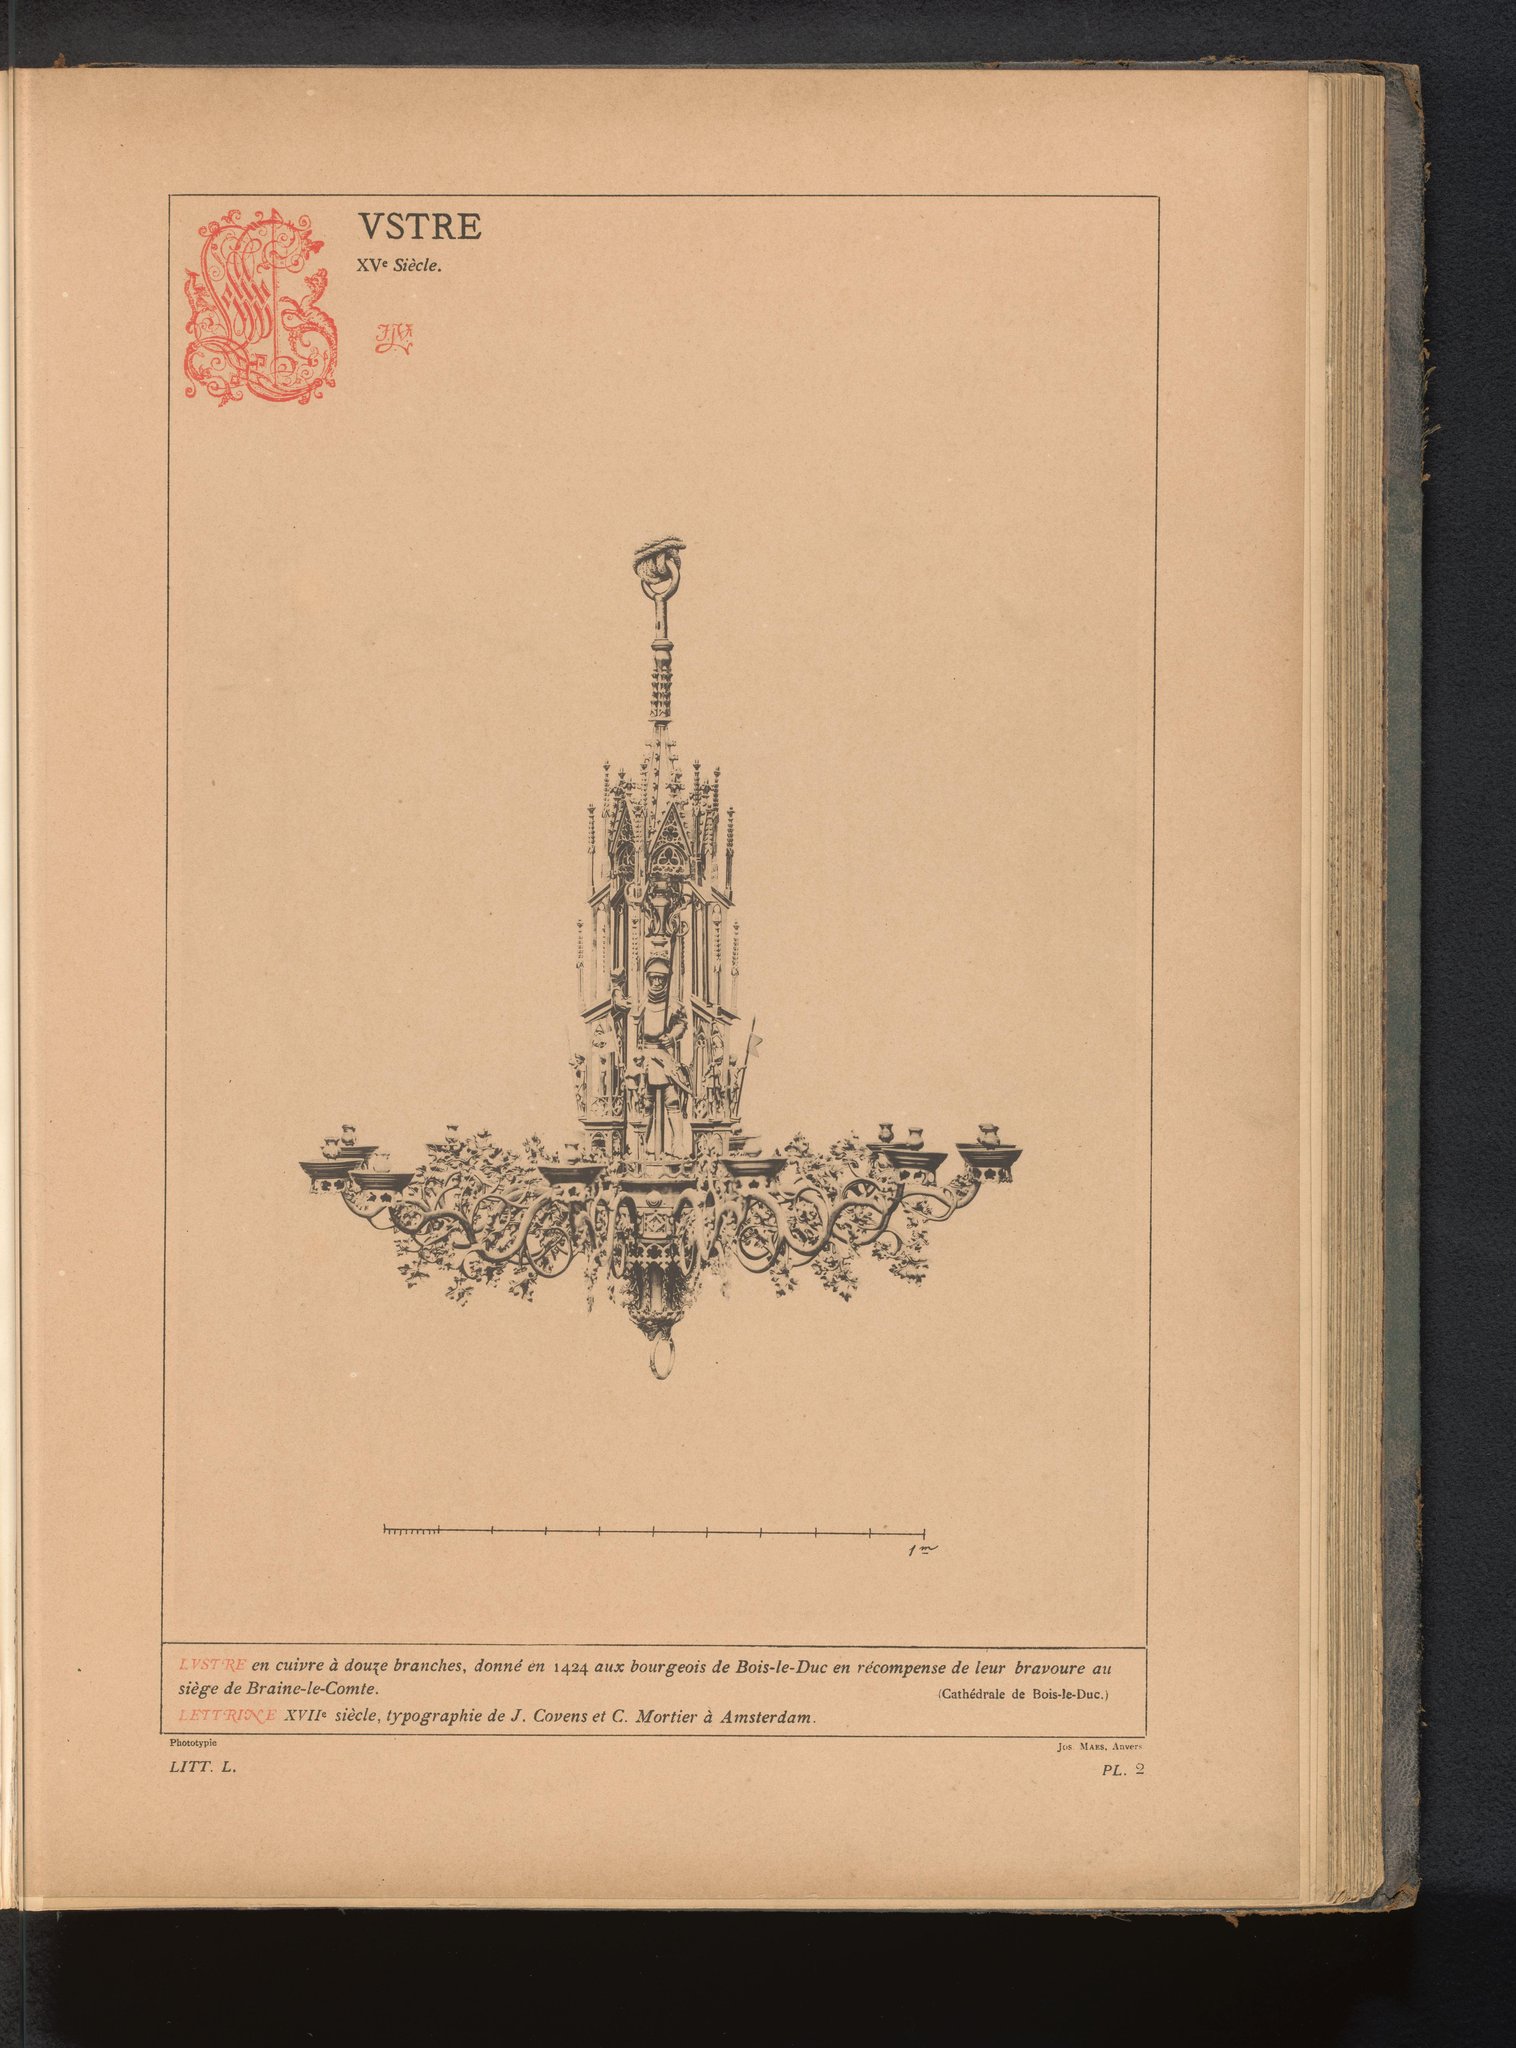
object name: photomechanical print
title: Koperen kroonluchter met twaalf armen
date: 1875-1880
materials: paper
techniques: photograph, photolithography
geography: amsterdam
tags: chandelier, candelabrum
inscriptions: inscription: ‘LUSTRE en cuivre (...)’, inscription: ‘LITT. L. - PL. 2’, monogram: ‘JJvY’